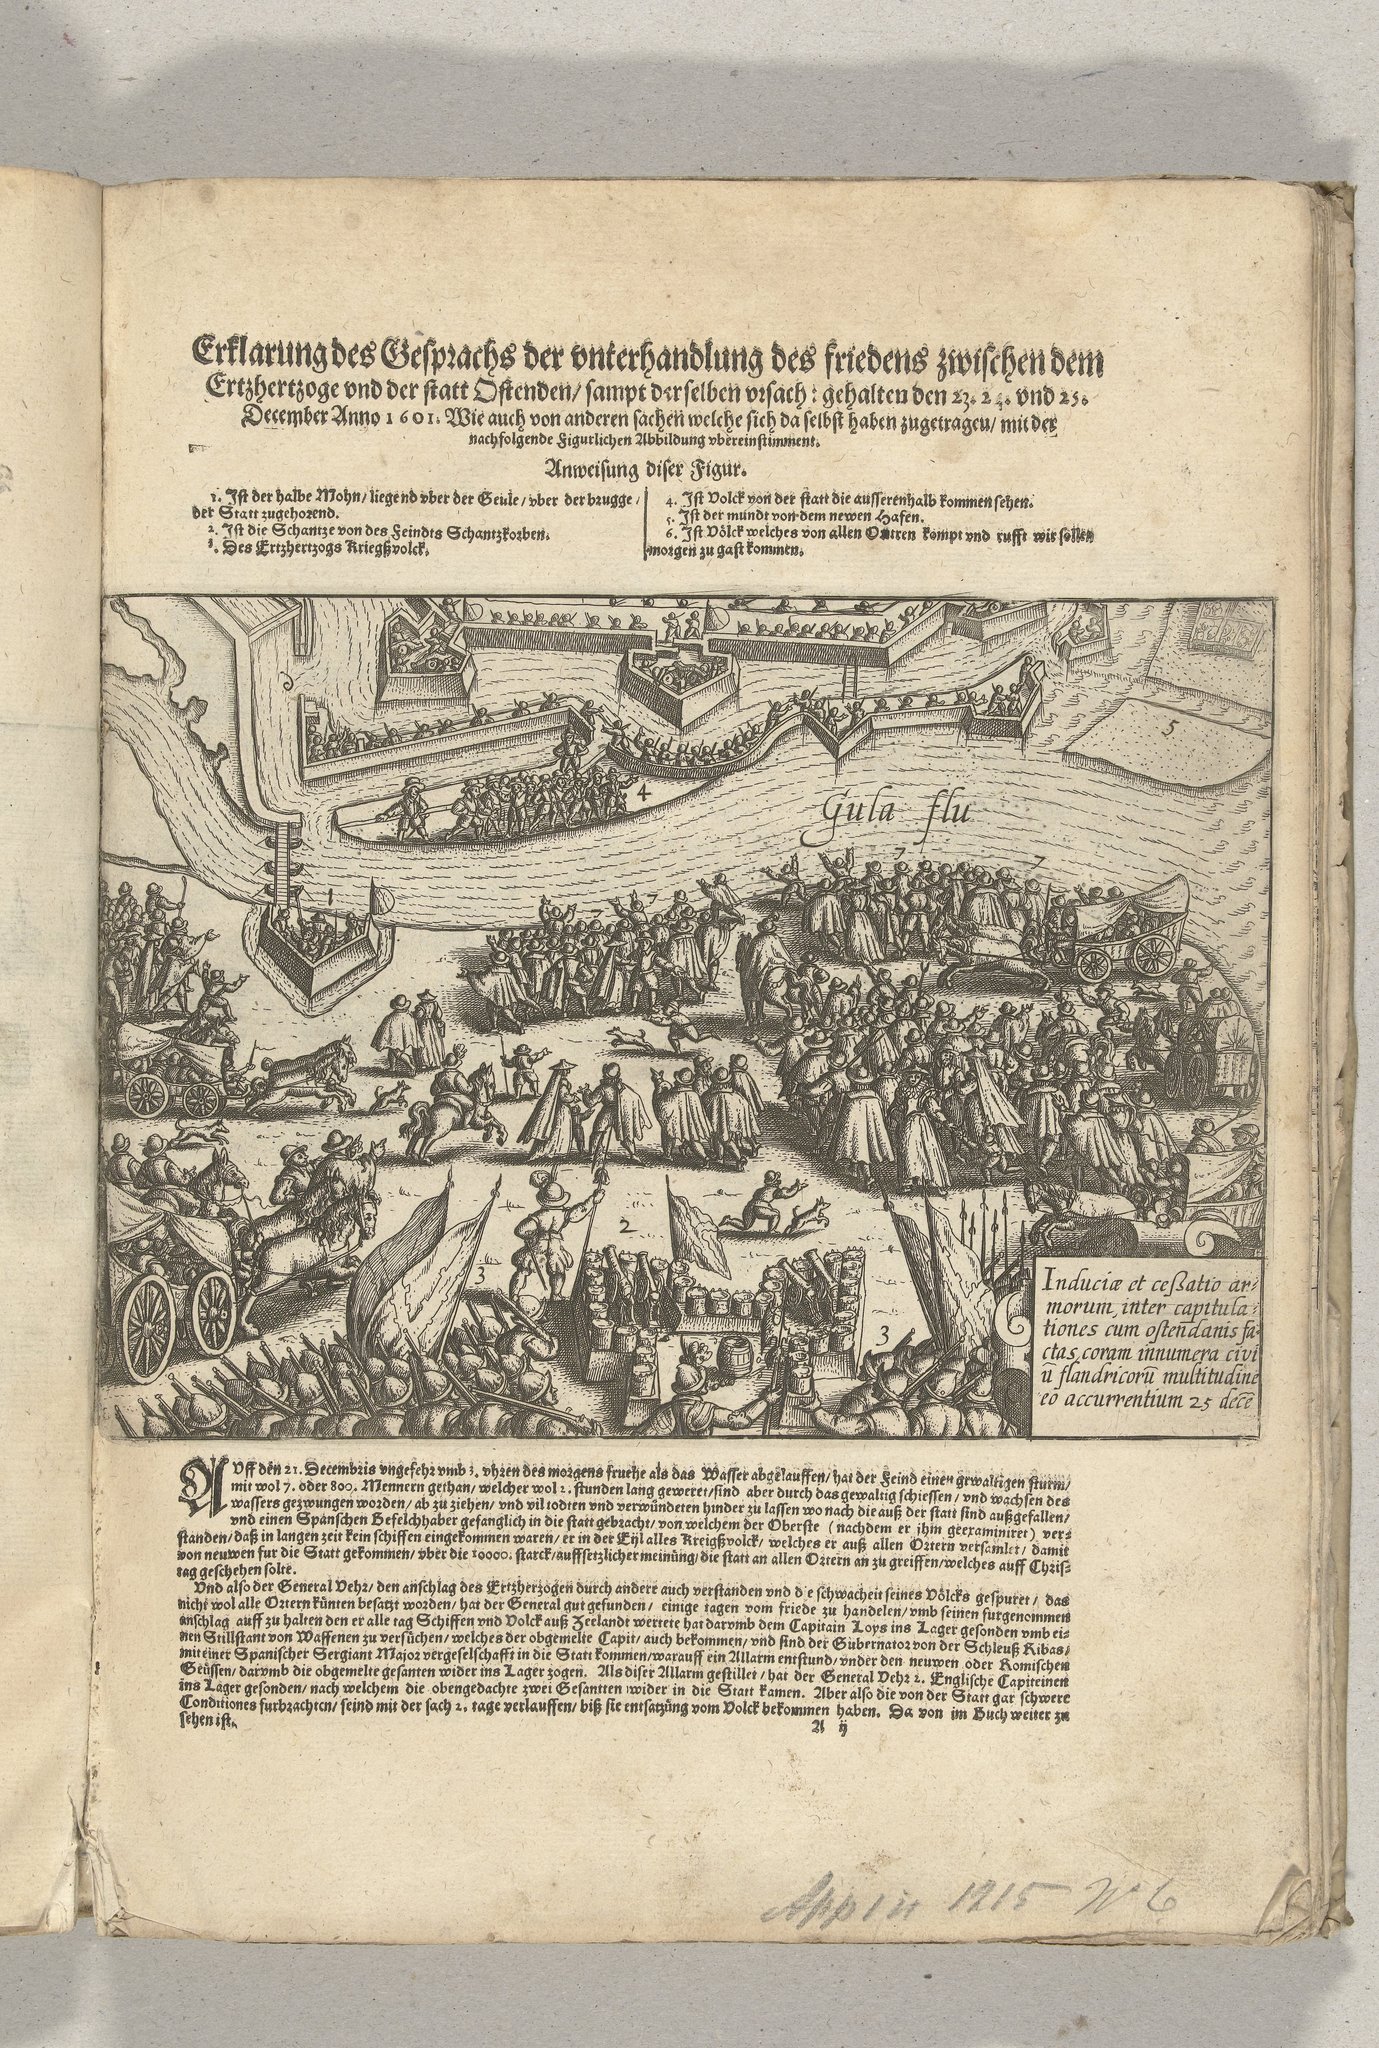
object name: print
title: Erklarung des Gesprachs der unterhandlung des friedens zwischen dem Ertzhertzoge und der statt Ostenden / sampt derselben ursach: gehalten den 22. 24. und 25. December Anno 1601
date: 1601-1604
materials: paper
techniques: etching, letterpress printing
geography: low countries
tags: siege, position war, proclamation of peace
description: Onderdeel van illustraties in: Belaegerung der Statt Ostende : Journal: Tagregister... aller gedenckwurdigsten Sachen... so inner und ausserhalb... sich zugetragen... von 5 July 1601. biss auff diese.. Herbstmisse Anno 1604... auss der Niderlendischen in die Hochteutsche Sprach transferirt, Und mit: Journal. Ander theil uber die Belägerung der statt Ostende biss auf die Herbstmiss in Sept. 1604 bey gefugt Mappa der Statt Ostende neben dem abriss des Parvae und Novae Troiae, s.l., 1604, fol°, ill. Hierbij gevoegd enkele prenten voorzien van Duitse teksten, 1604 (z.n., z.p.). In het exemplaar in de collectie van de Rijksmuseum Research Library (326 F 10).